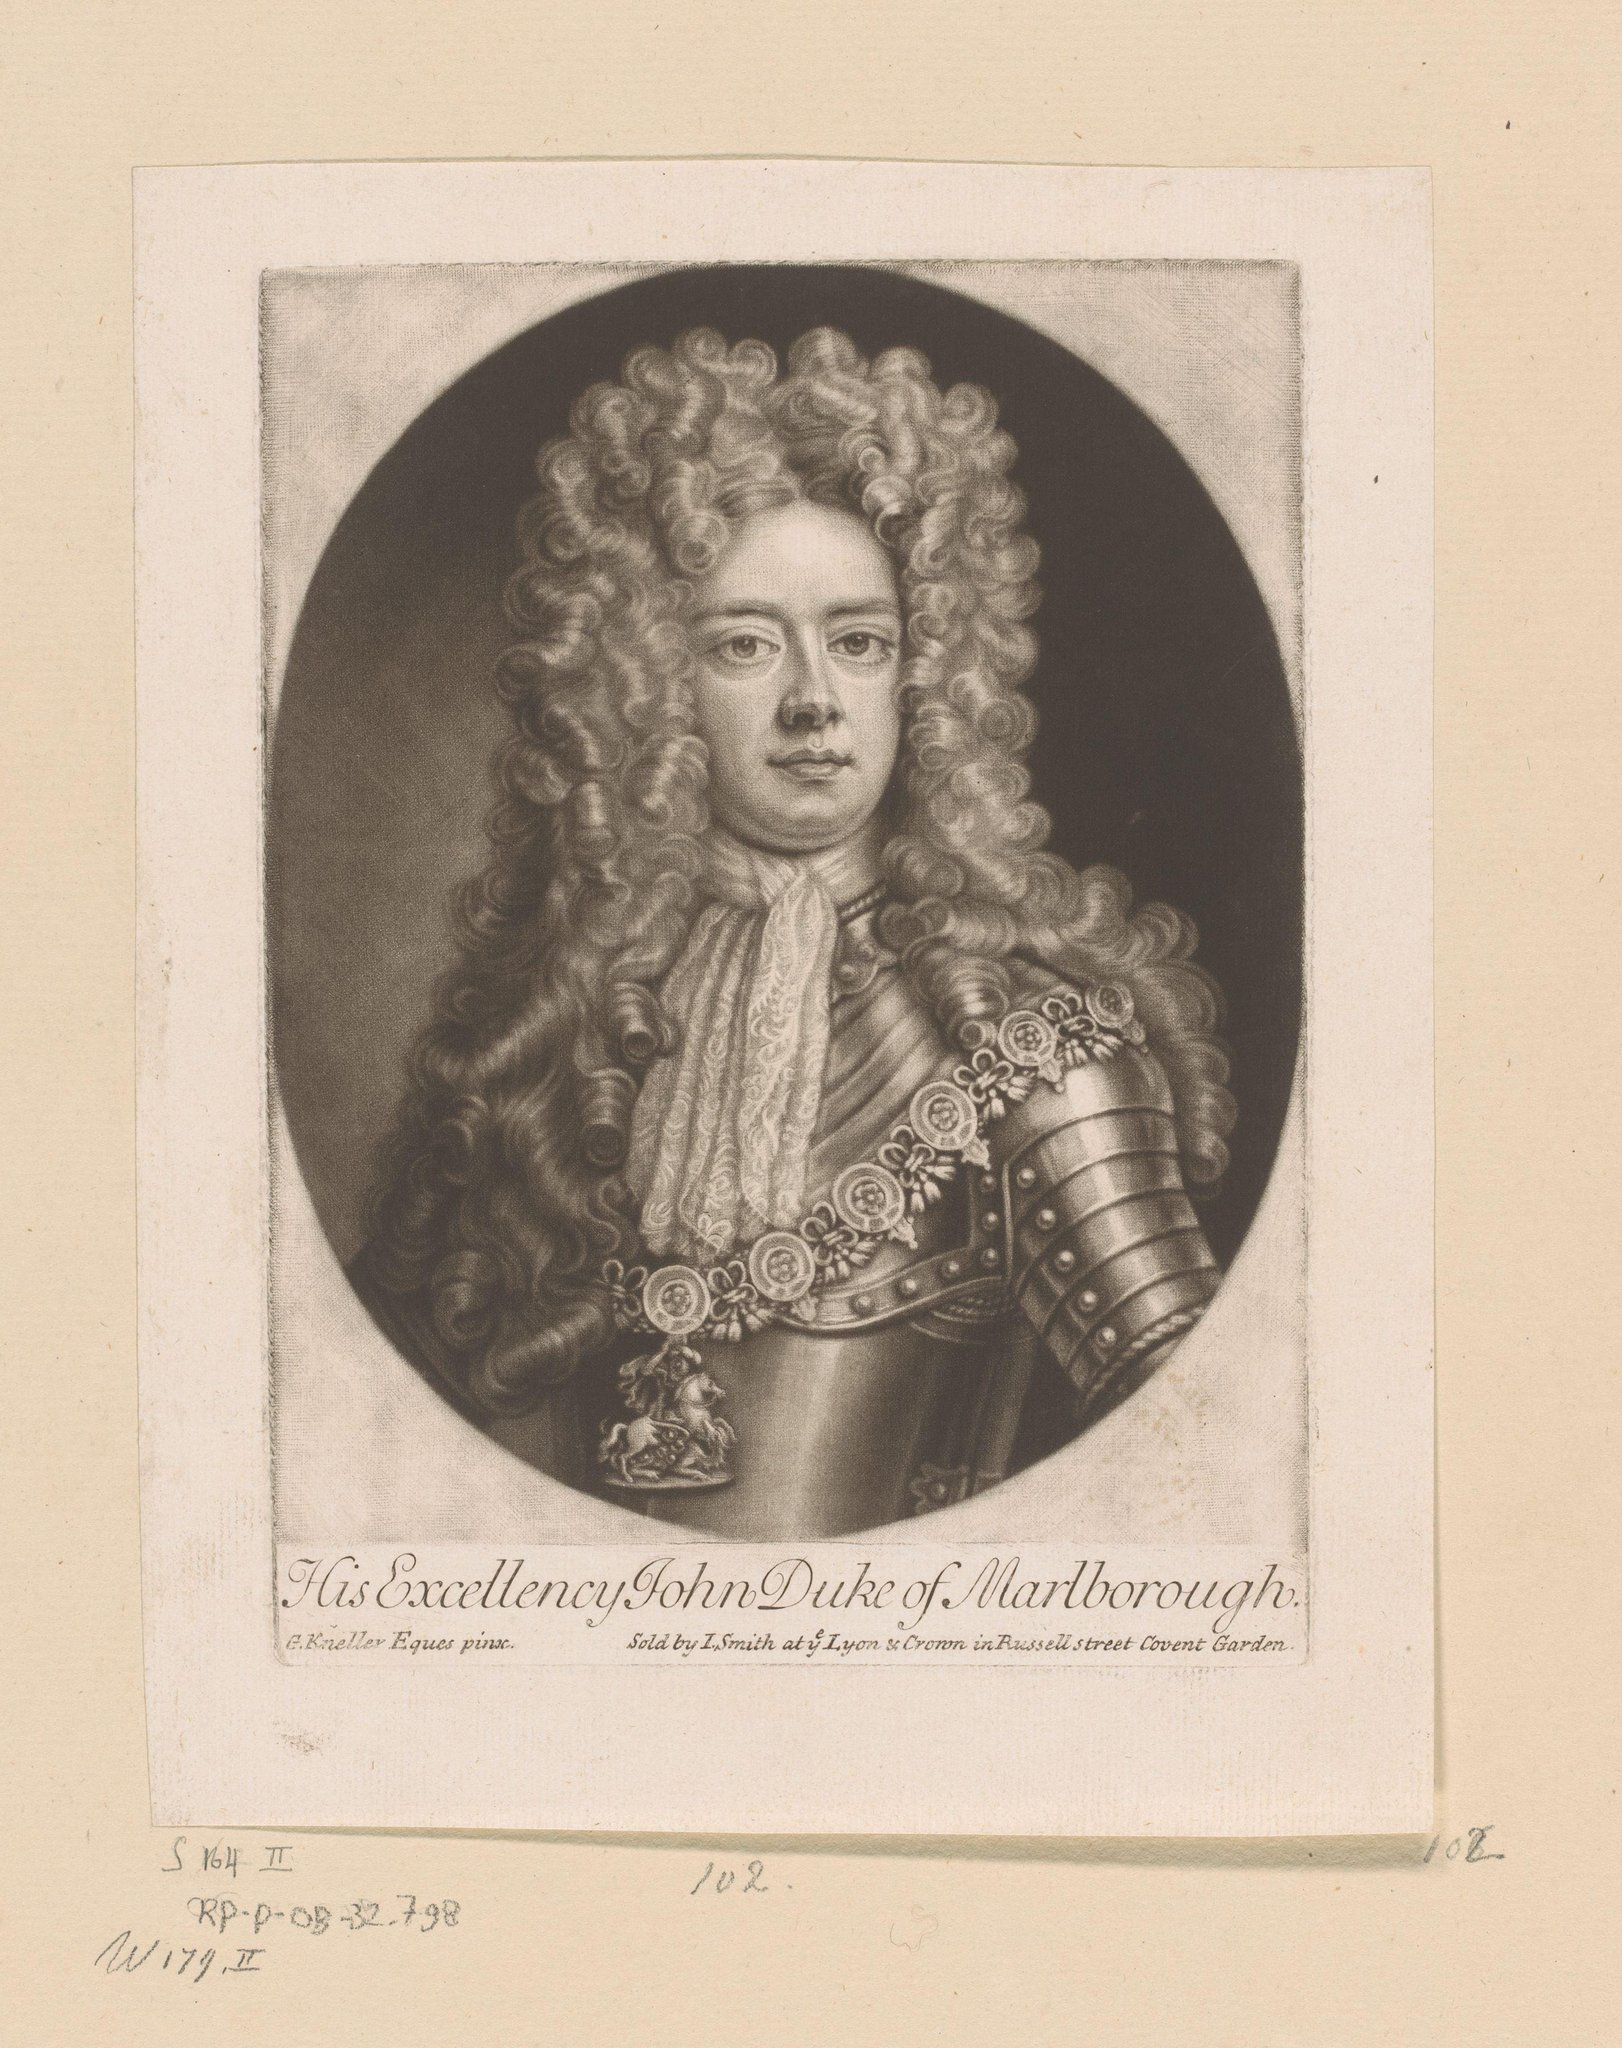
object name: print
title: His Excellency John Duke of Marlborough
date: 1662-1742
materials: paper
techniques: mezzotint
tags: john churchill (1e hertog van marlborough), historical persons, commander-in-chief, admiral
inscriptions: collector's mark: Lugt 240